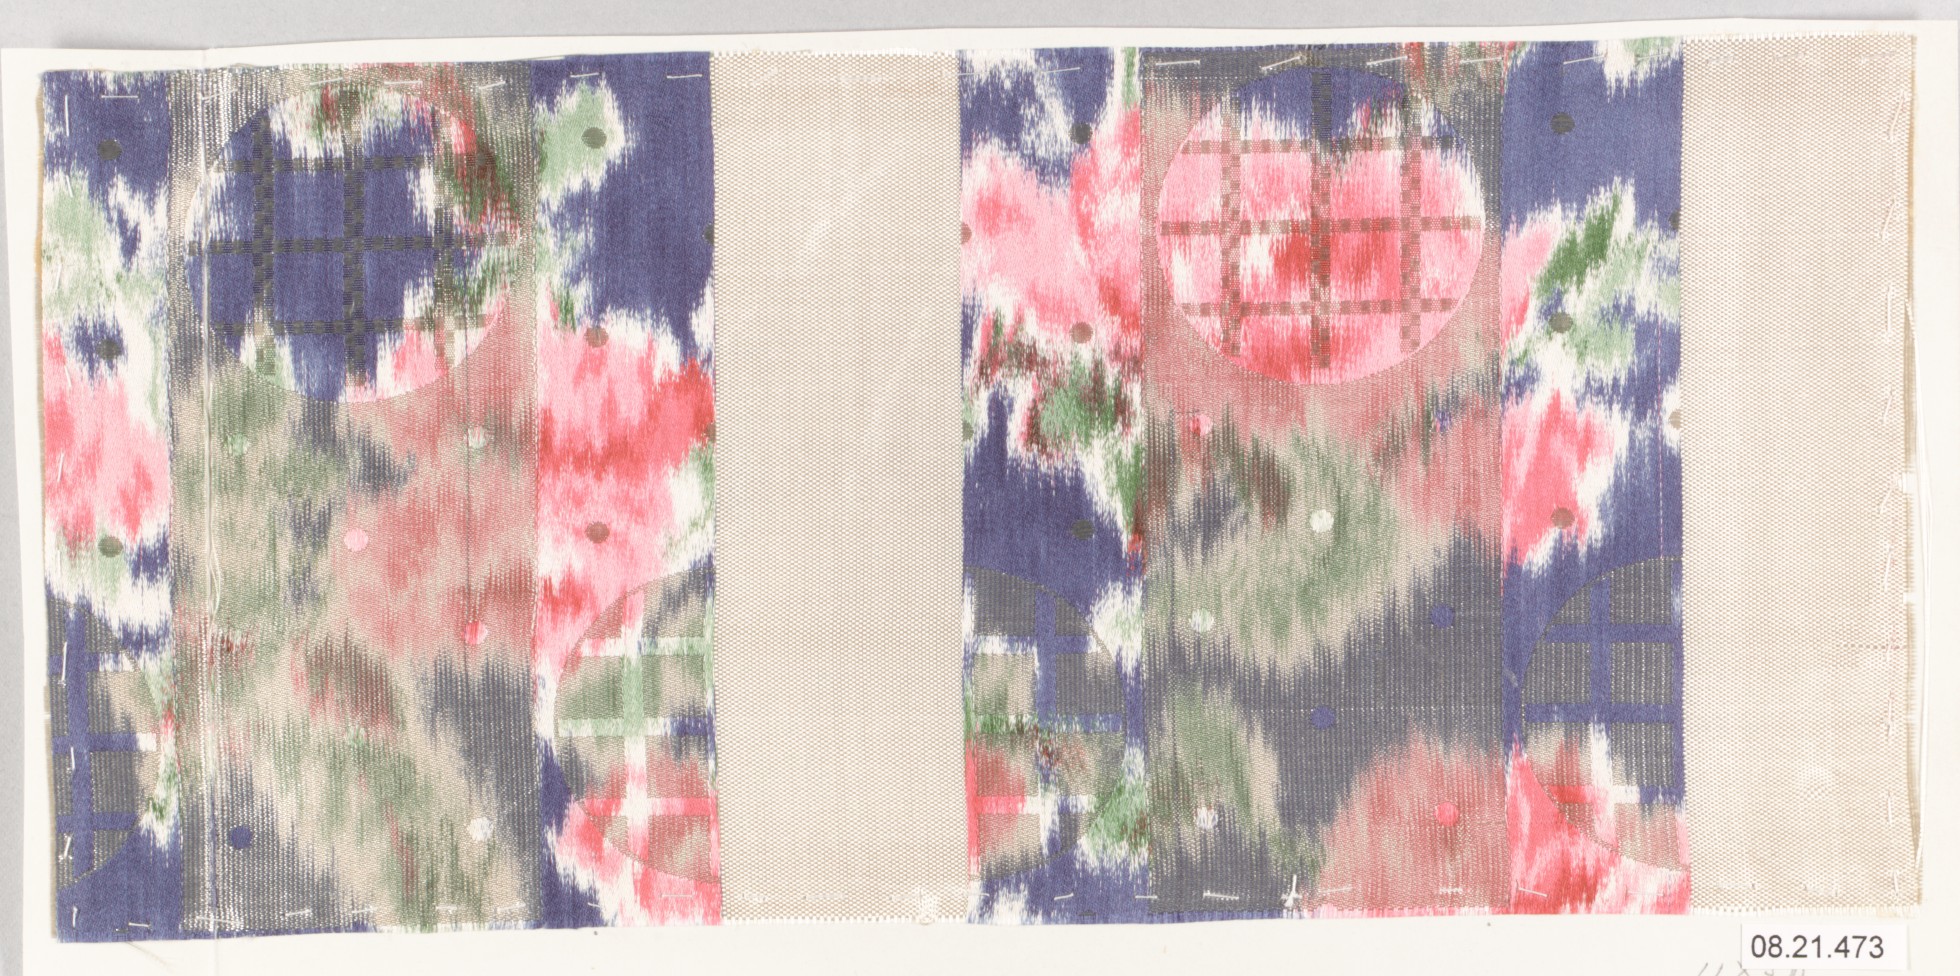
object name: textile sample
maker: Anonymous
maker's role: designer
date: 1900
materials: silk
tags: flowers